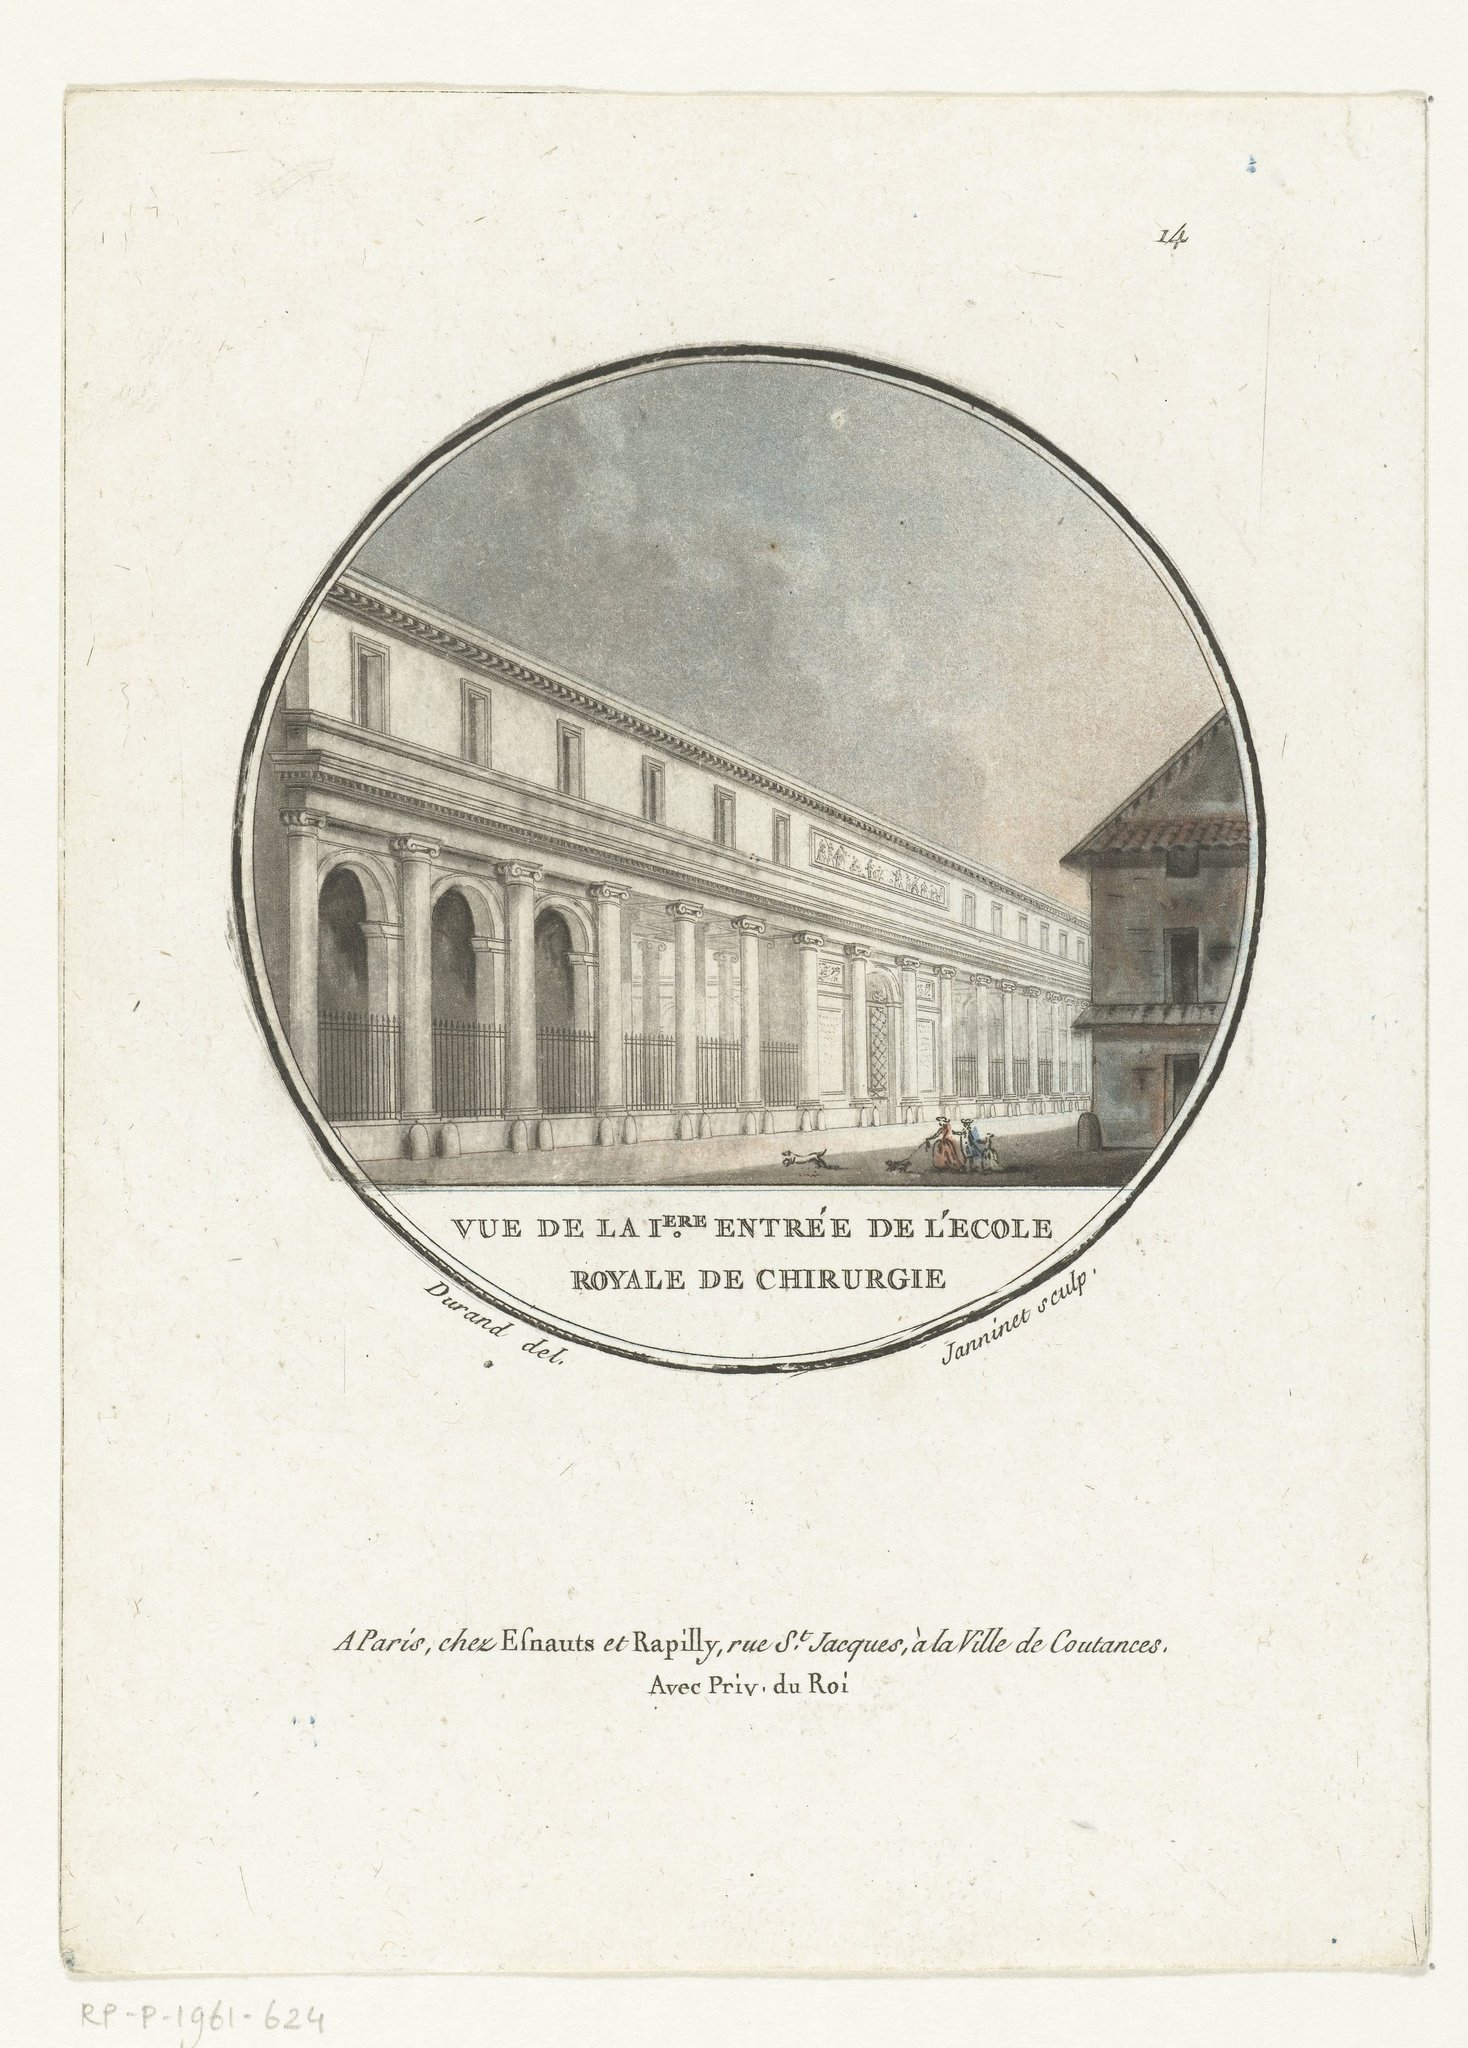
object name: print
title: Vue de la 1ere entrée de l'Ecole royale de Chirurgie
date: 1772-1792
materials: paper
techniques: etching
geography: paris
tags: medicine, medical science, scholastic education, tuition (+ building ~ education, tuition), paris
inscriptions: collector's mark: Lugt 2228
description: De hoofdingang van de school voor chirurgie te Parijs. Uit een serie van 73 prenten met afbeeldingen van de belangrijkste gebouwen van Parijs.